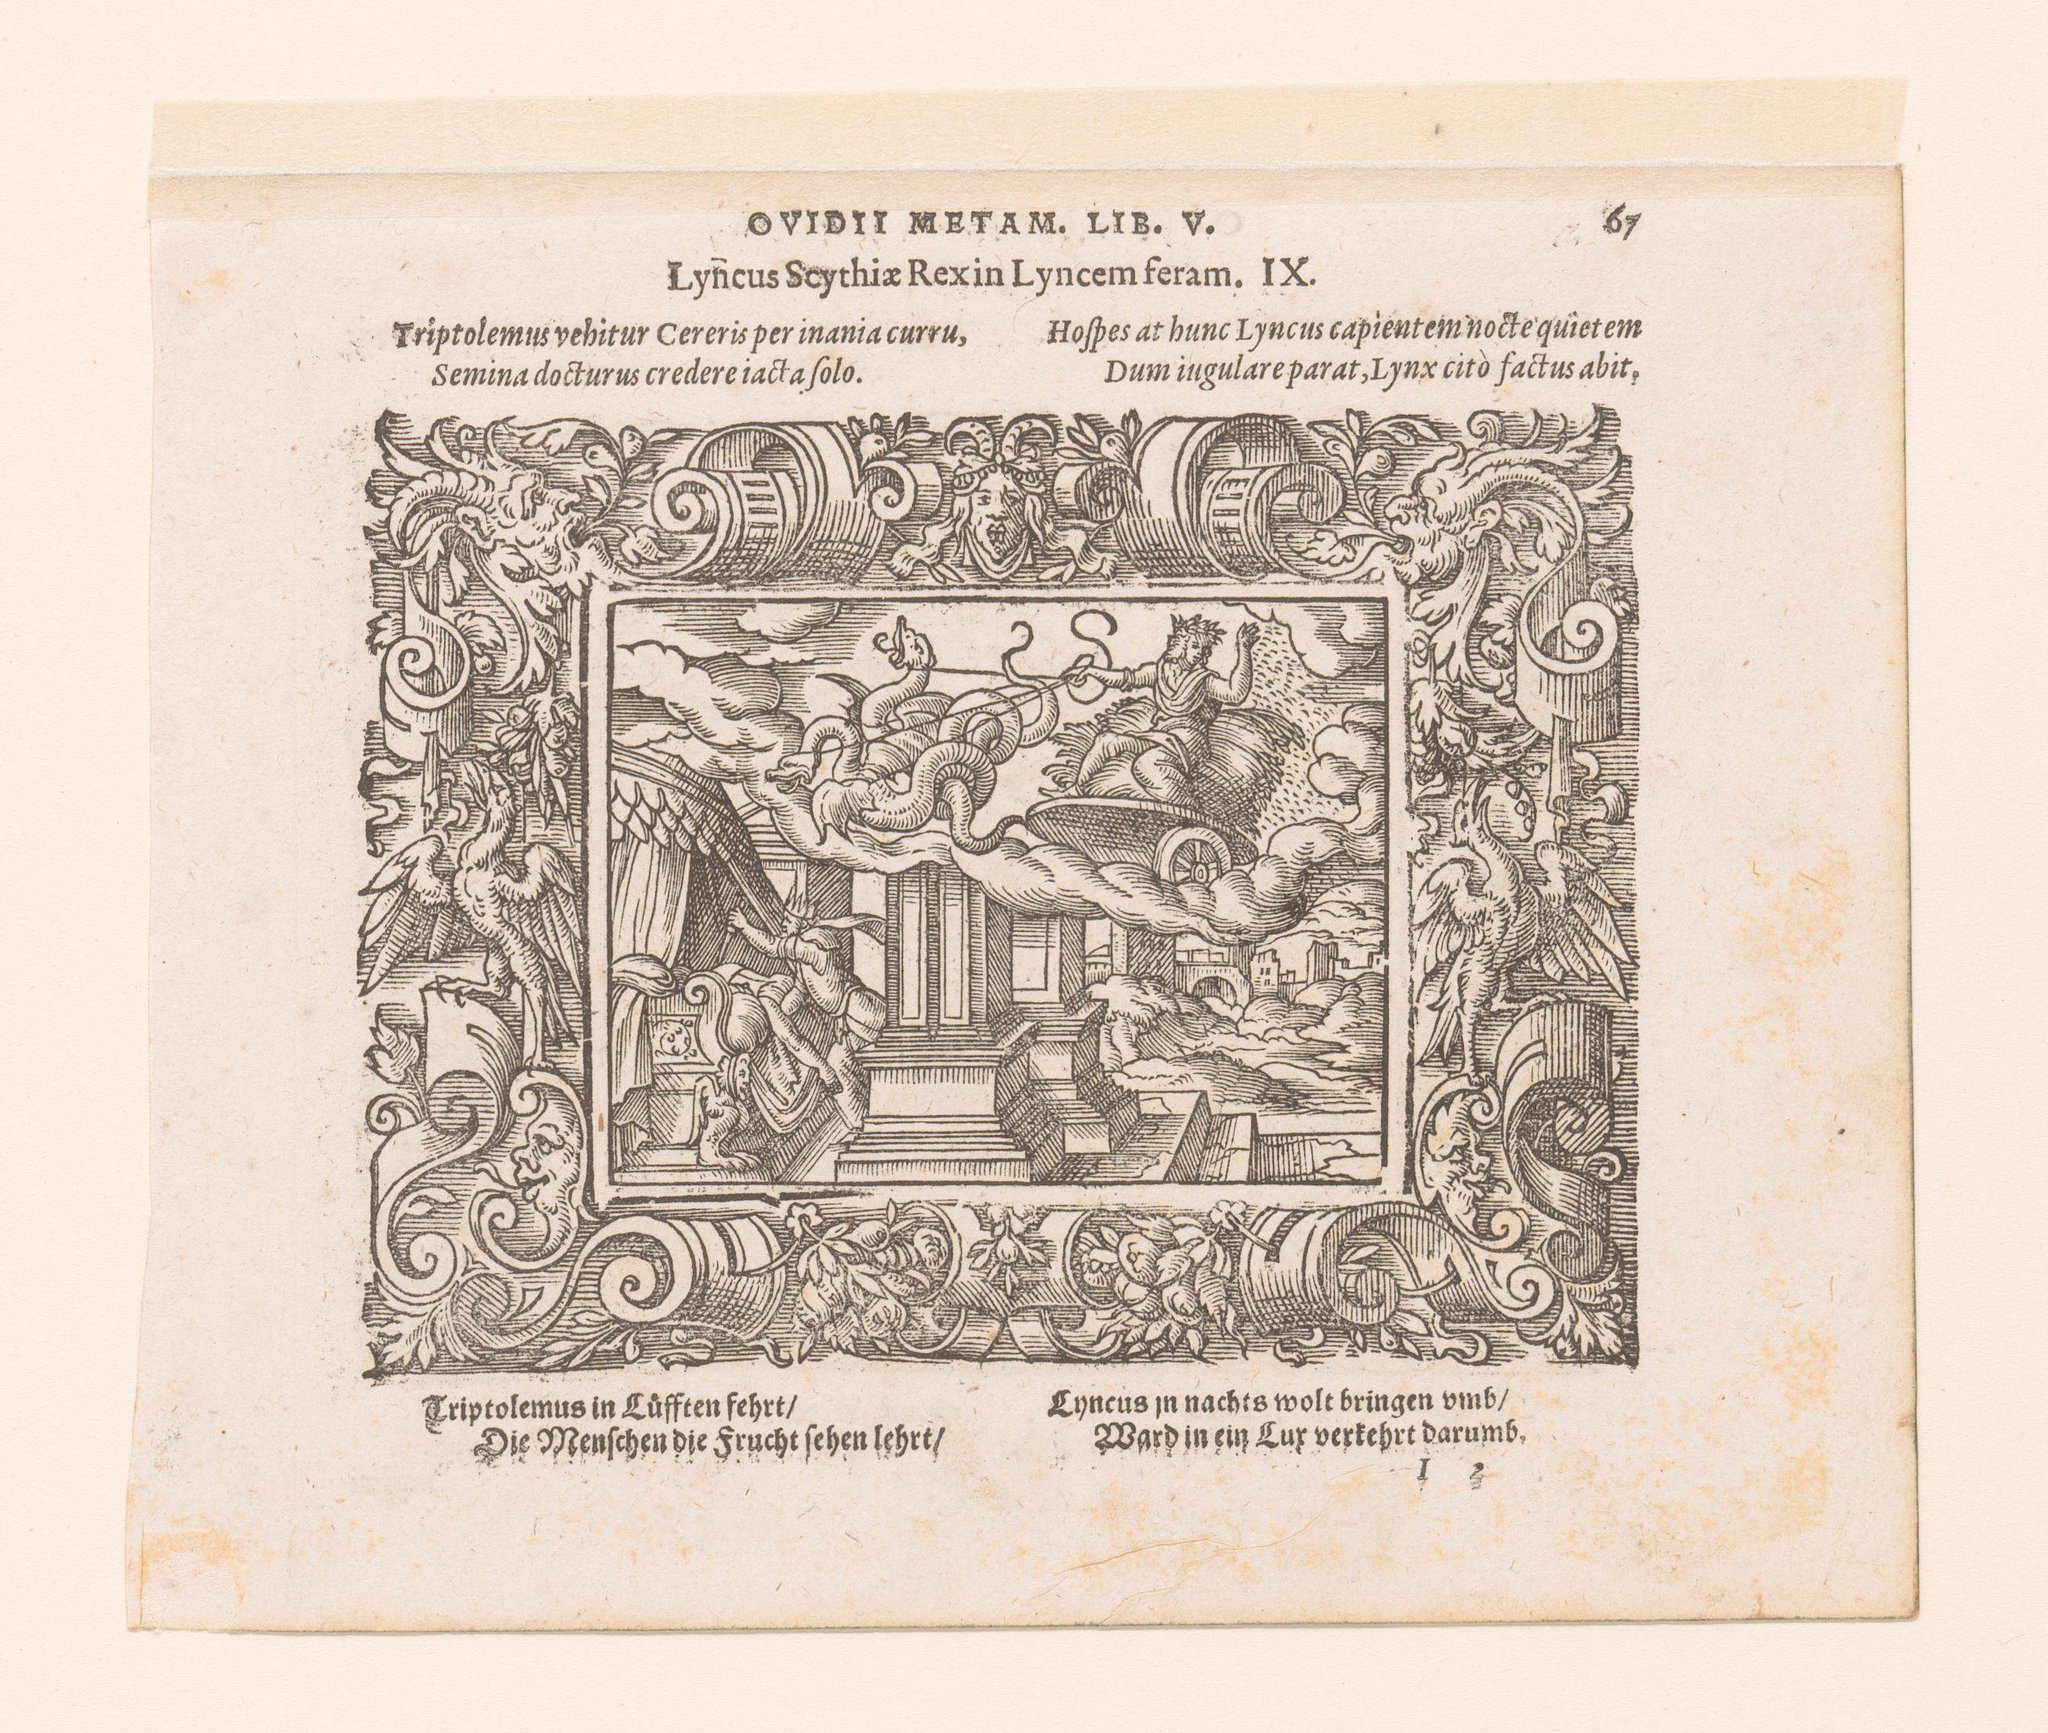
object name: print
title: Ceres verhindert de moord op Triptolemus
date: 1569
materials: paper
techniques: letterpress printing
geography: frankfurt am main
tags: scrollwork, strapwork ~ ornament, lyncus changed into a lynx: ceres changes lyncus into a lynx when he is on the point of murdering the sleeping triptolemus (ovid, metamorphoses v 657)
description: Illustratie bij de Metamorfosen van Ovidius, afkomstig uit de publicatie: Posthius, Johannes. Tetrasticha in Ovidii metam. Frankfurt am Main: Georg Rab en Sigmund Feyerabend en erven Weigand Han, 1569. De voorstellingen en ornamentranden van deze boekillustraties zijn van twee aparte blokken gedrukt. Beide werden afzonderlijk van elkaar ook gebruikt voor andere publicaties, en de ornamentranden werden eveneens binnen deze publicatie meerdere keren gebruikt.